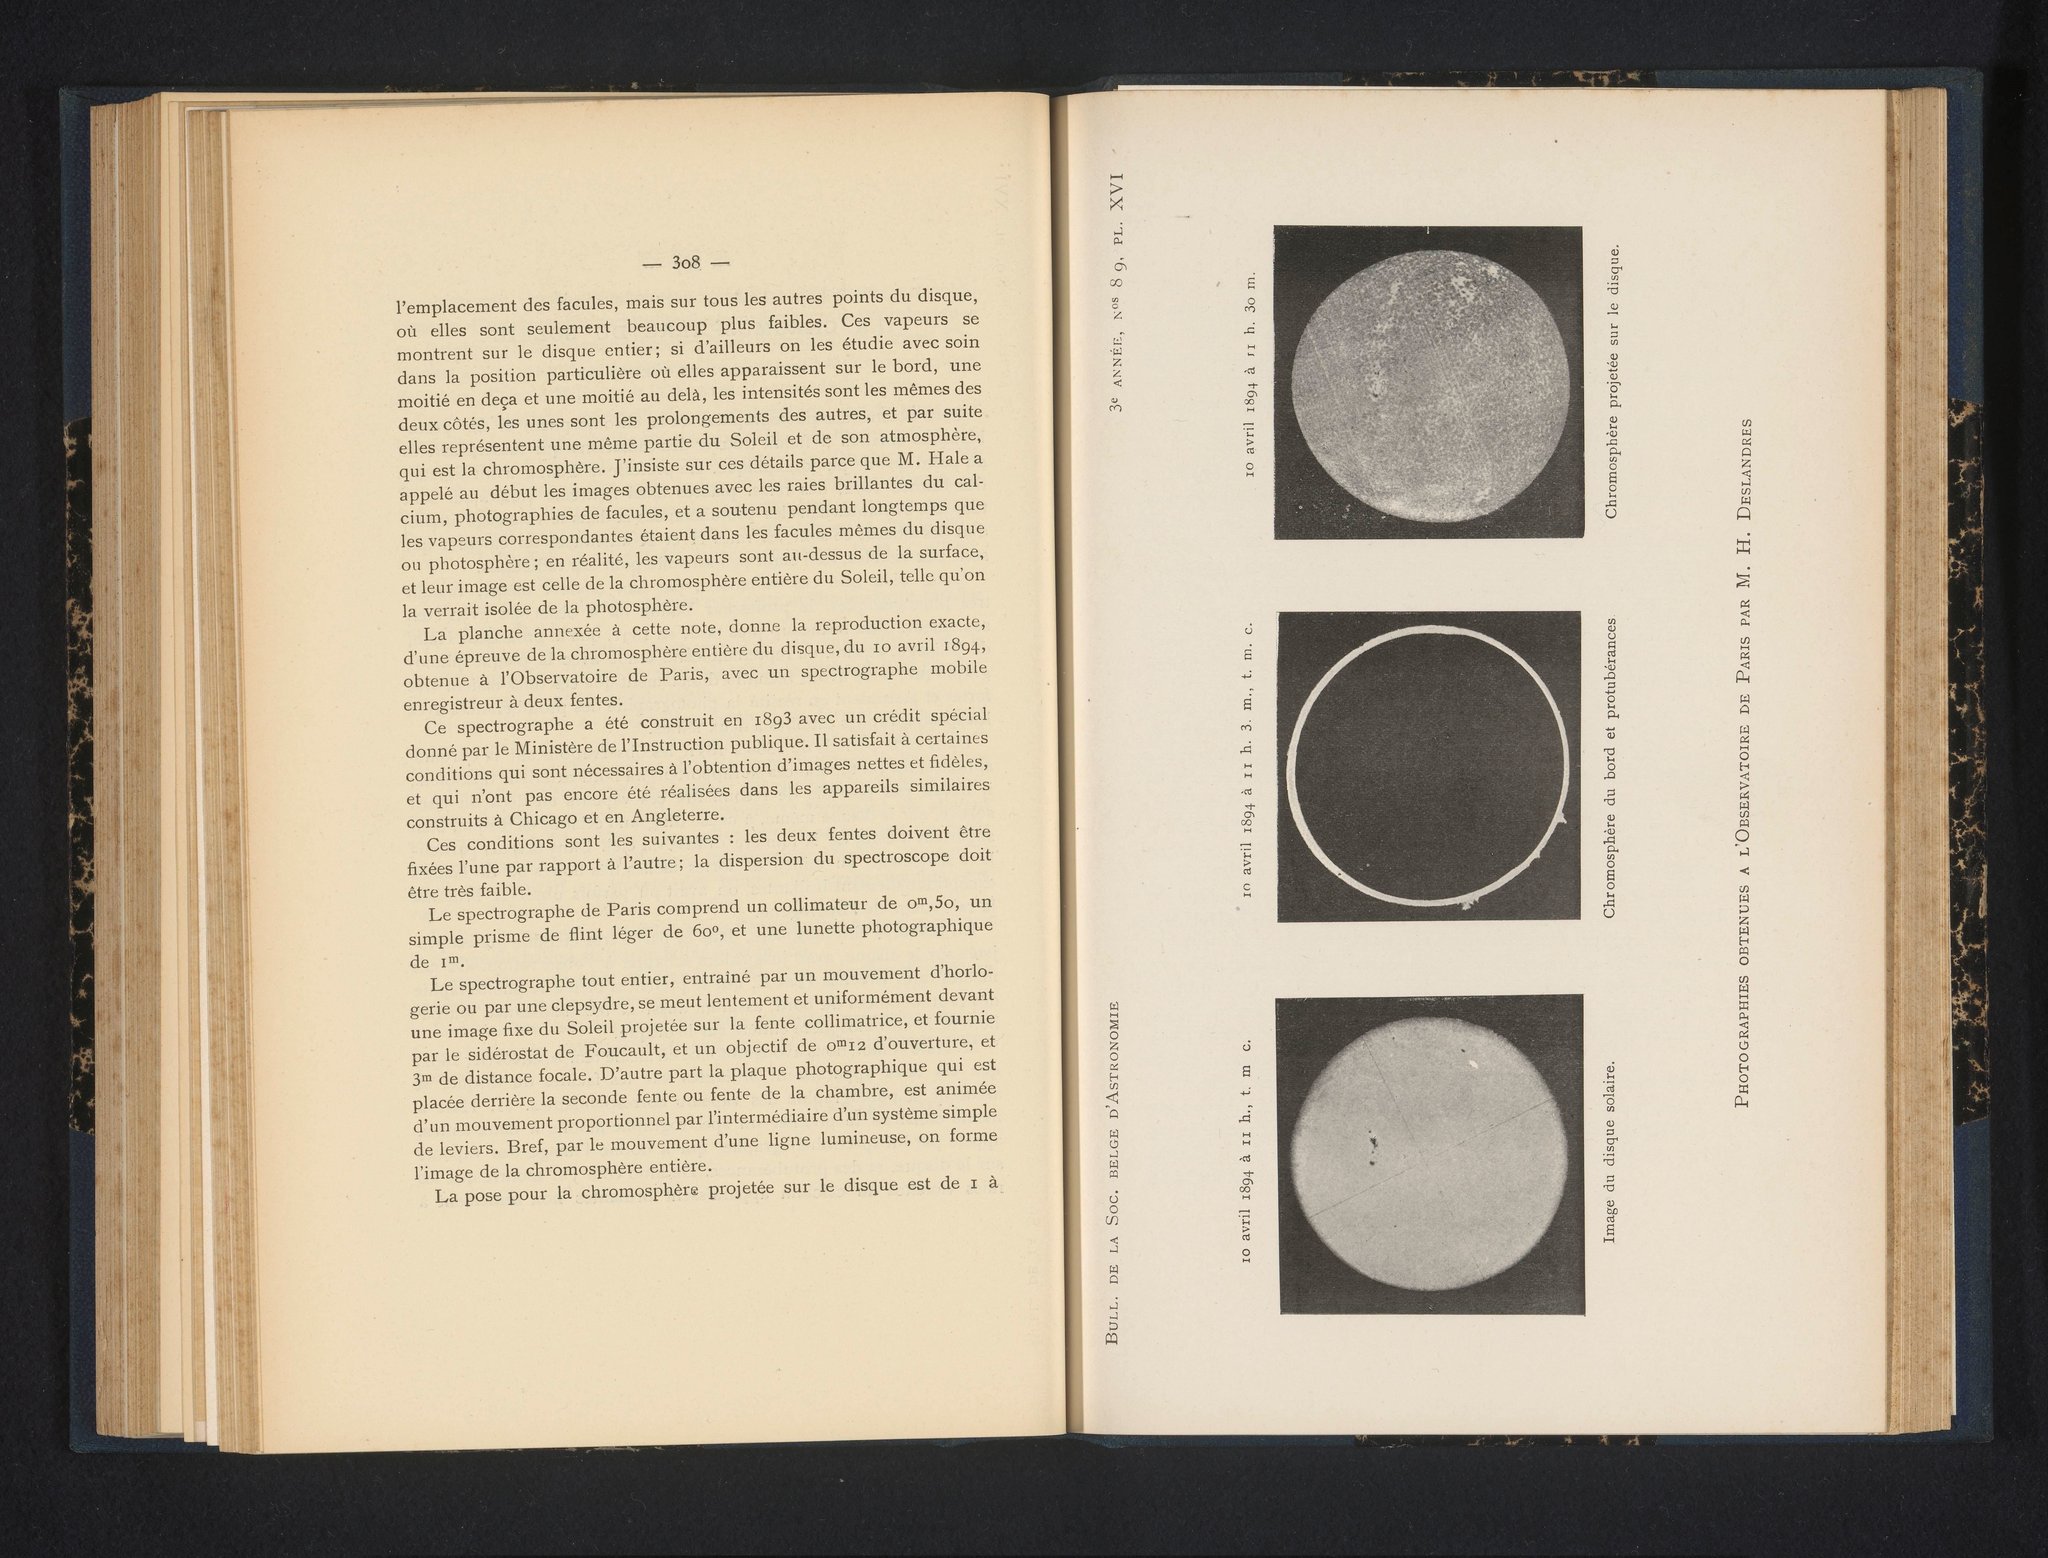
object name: page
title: Gezichten op de zon, de chromosfeer en de zon met de chromosfeer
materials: paper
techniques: autotype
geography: paris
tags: sun as celestial body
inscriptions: inscription: ‘3e Année, no 8,9, PL XVI’